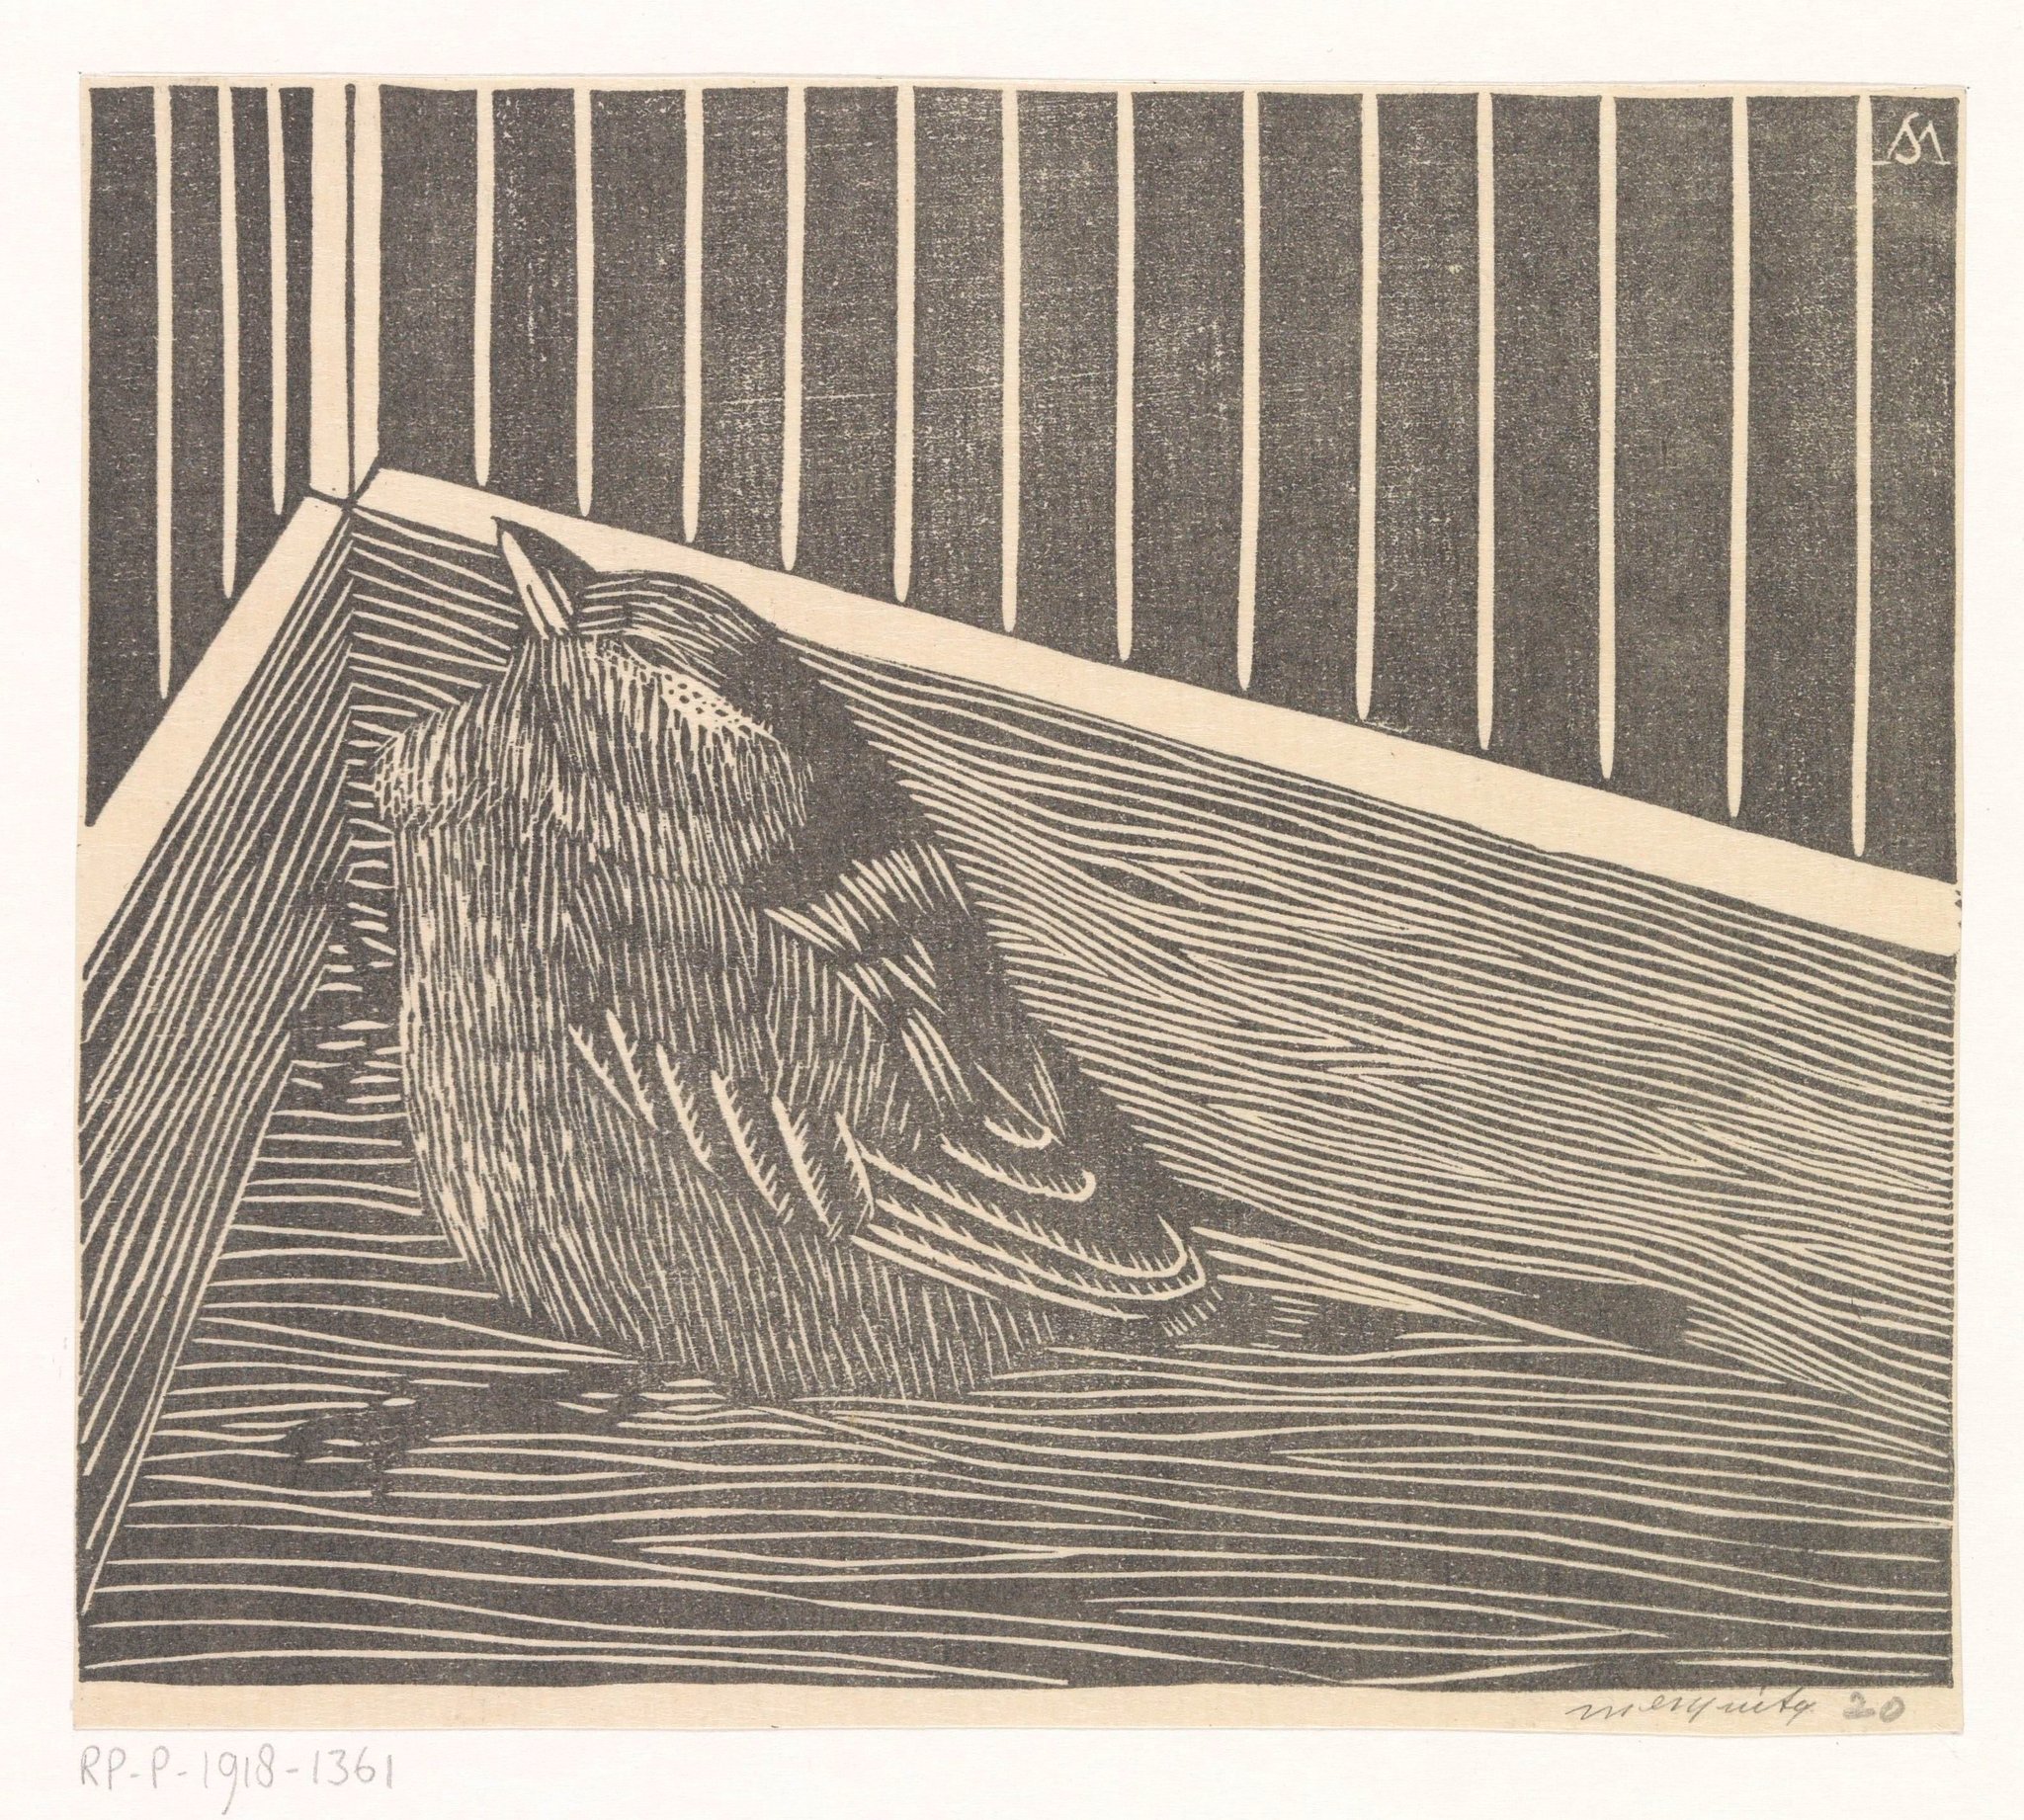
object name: print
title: Vogel in hoek van een kooi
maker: samuel jessurun de mesquita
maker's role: draughtsman, print maker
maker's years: 1868-1944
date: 1914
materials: paper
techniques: woodcut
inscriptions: signature: ‘mesquita 20’